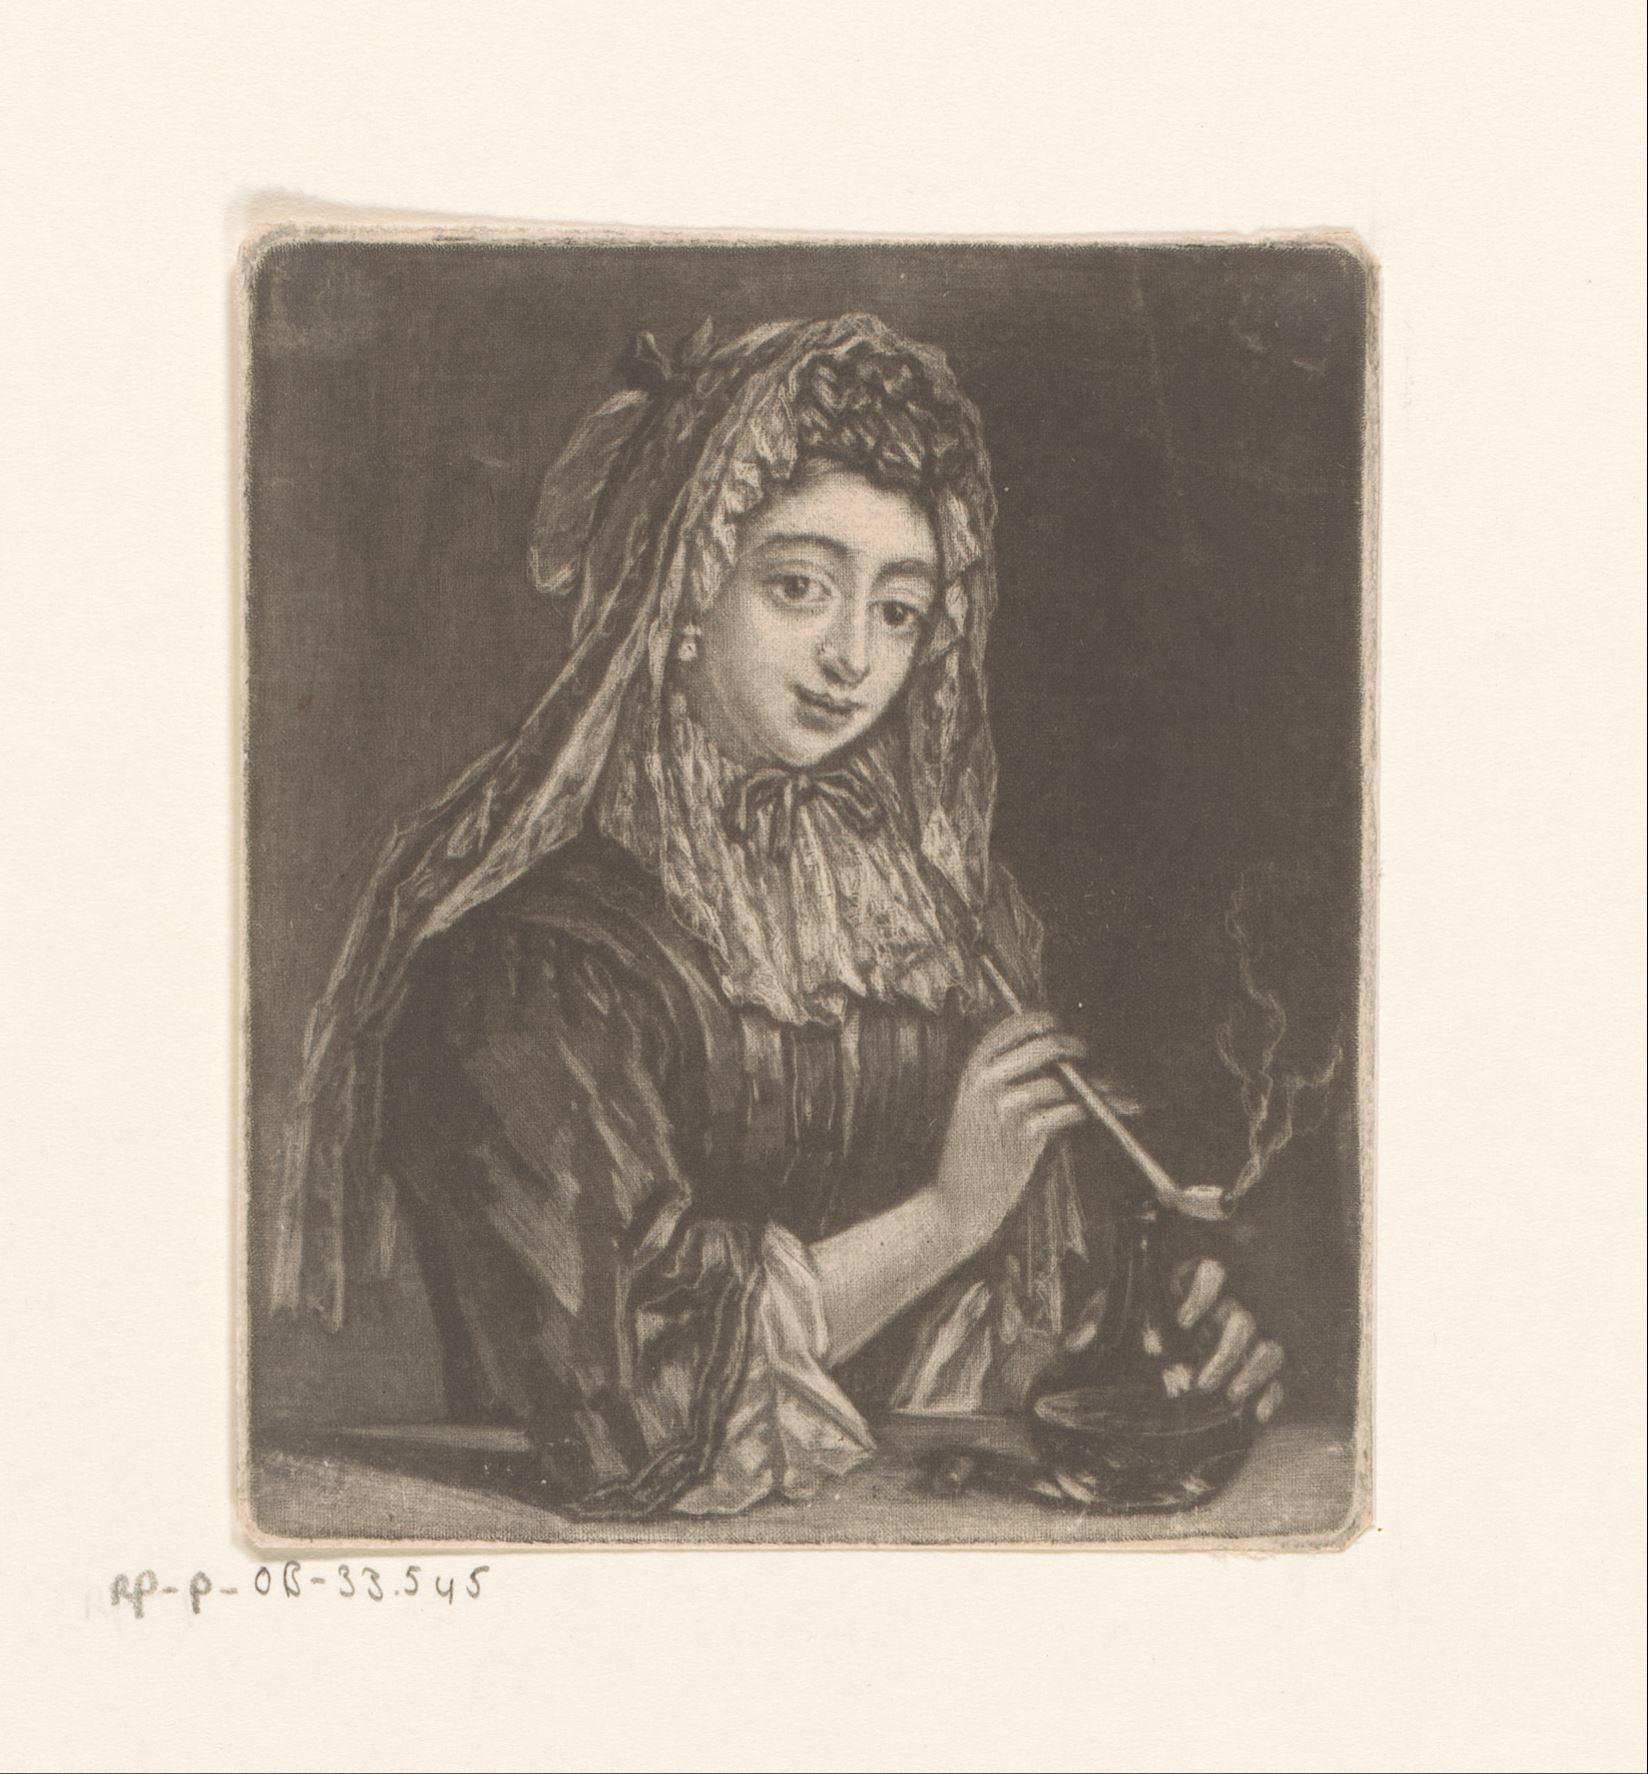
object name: print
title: Pijprokende vrouw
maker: Anonymous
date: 1680-1700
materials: paper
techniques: mezzotint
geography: england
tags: pipe ~ tobacco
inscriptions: collector's mark: Lugt 240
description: Zie een vergelijkbare prent met hetzelfde onderwerp, gespiegeld, in het British Museum: 1876,1111.36.